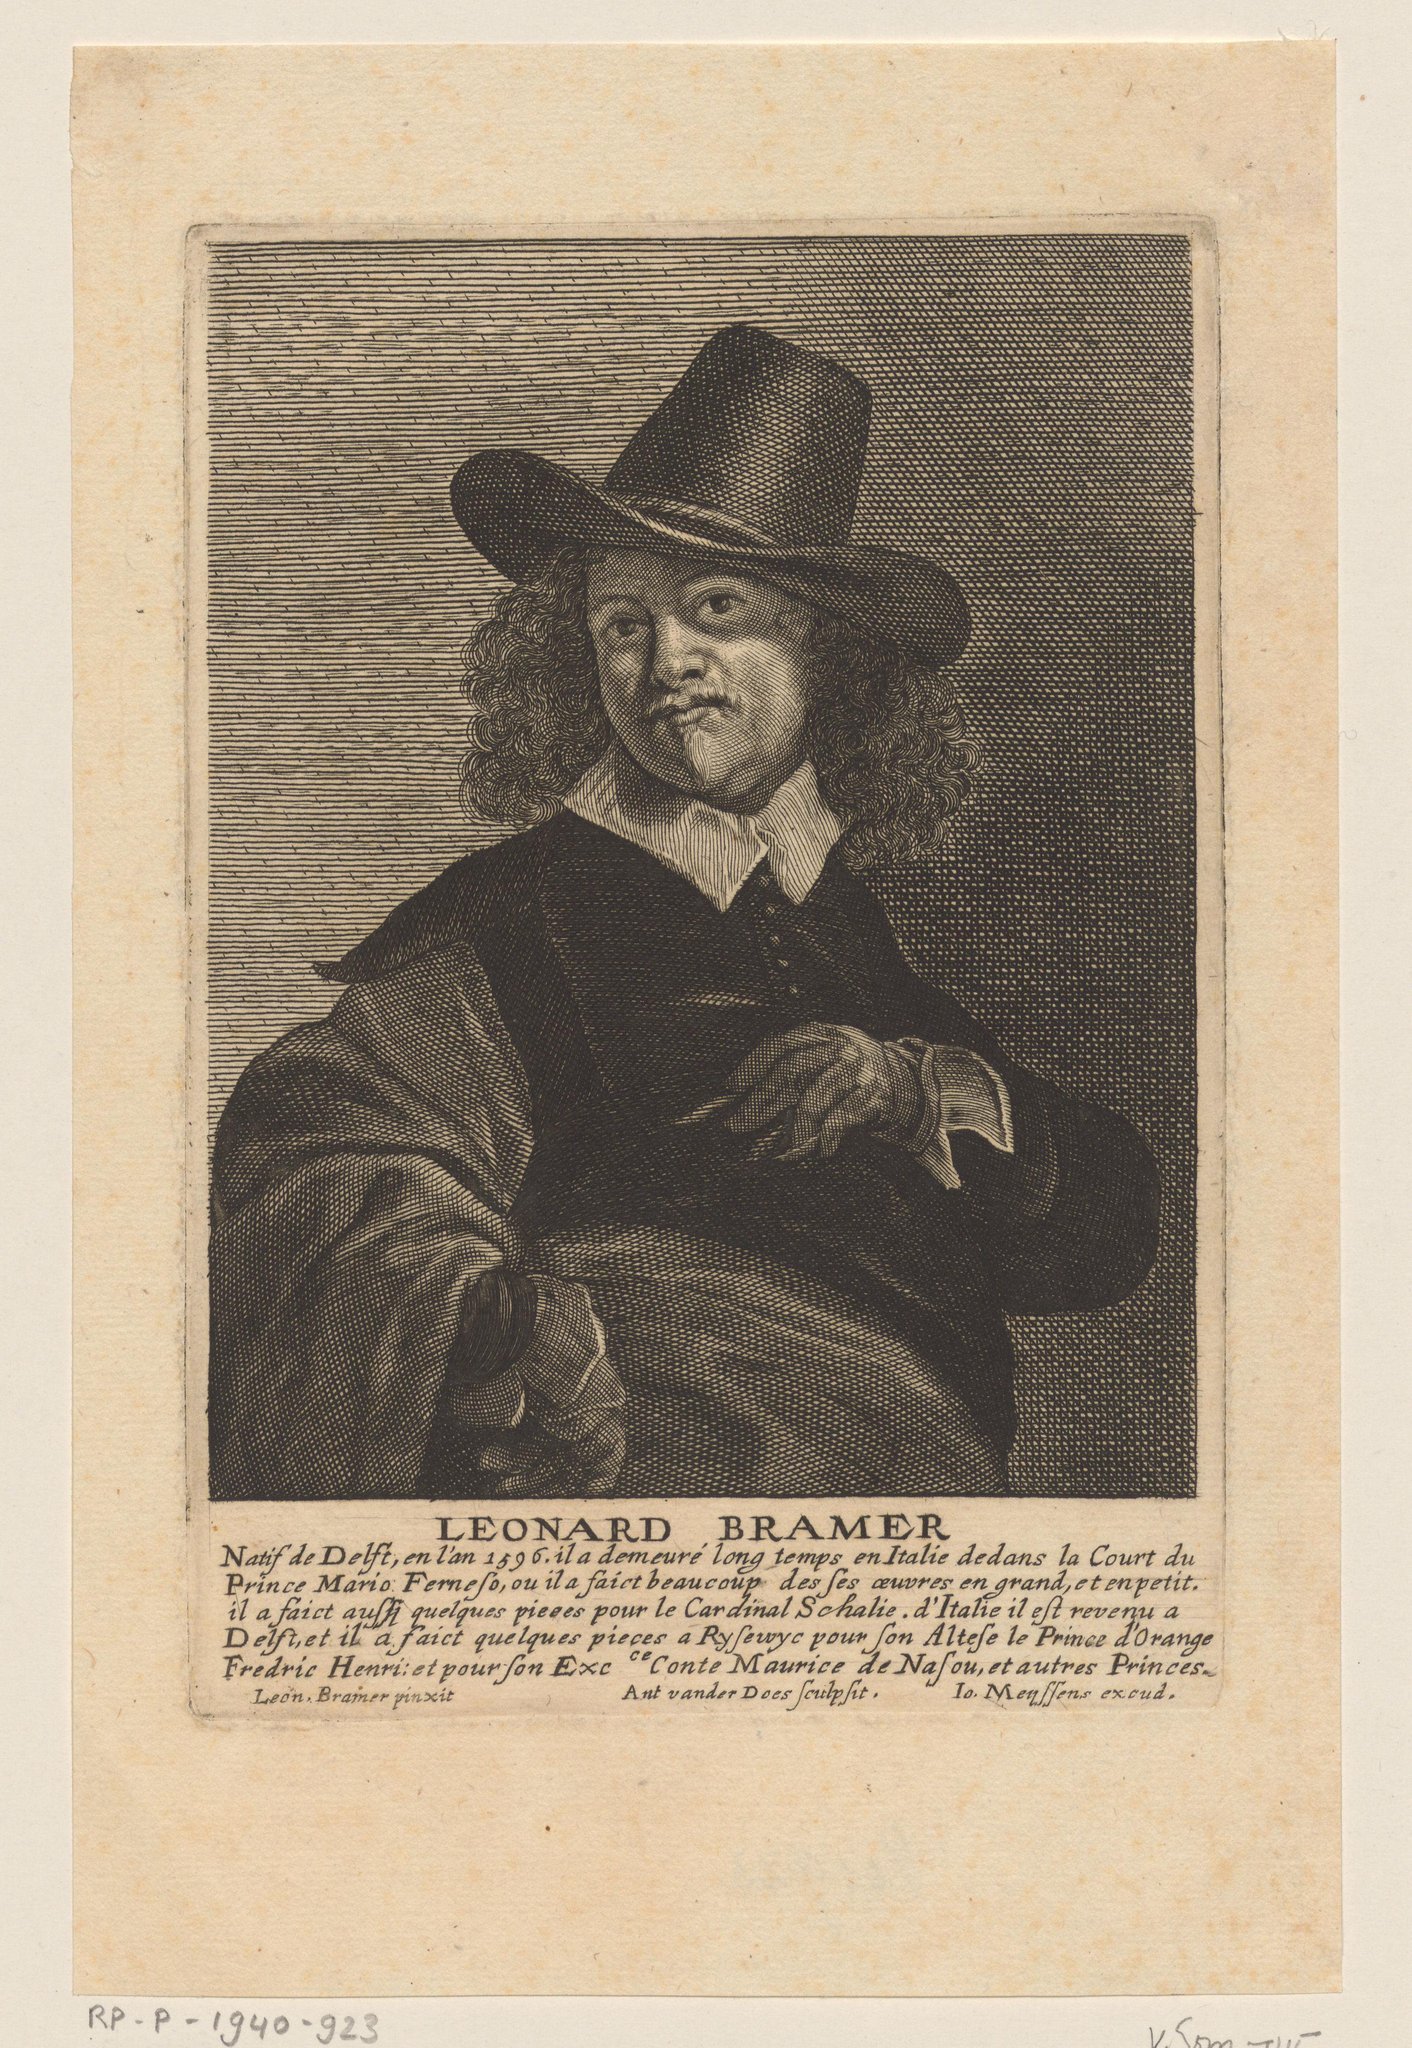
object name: print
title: Portretten van kunstenaars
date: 1649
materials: paper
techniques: engraving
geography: antwerp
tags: delft, painter, print maker, draughtsman, leonaert bramer, historical persons, portrait, self-portrait of artist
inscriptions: collector's mark: Lugt 2760, collector's mark: Lugt 2228